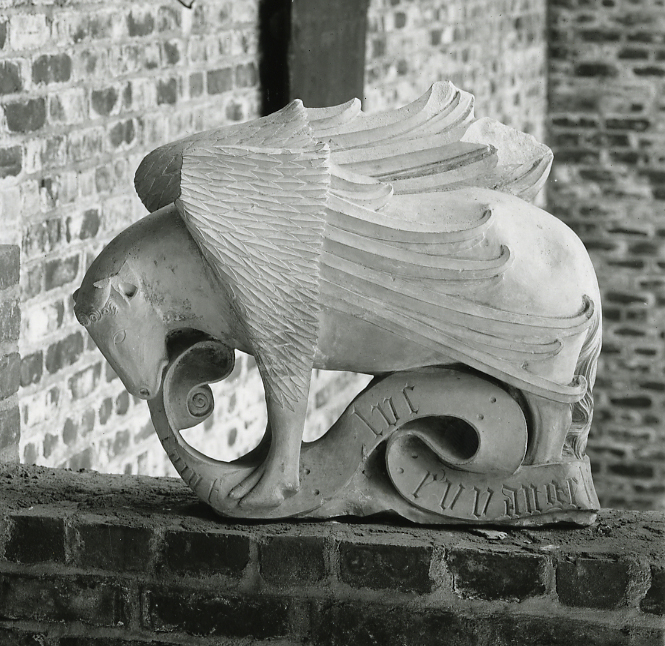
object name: sculpture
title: Sculpture of a Winged Ox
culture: french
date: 1301-1500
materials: stone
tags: ox